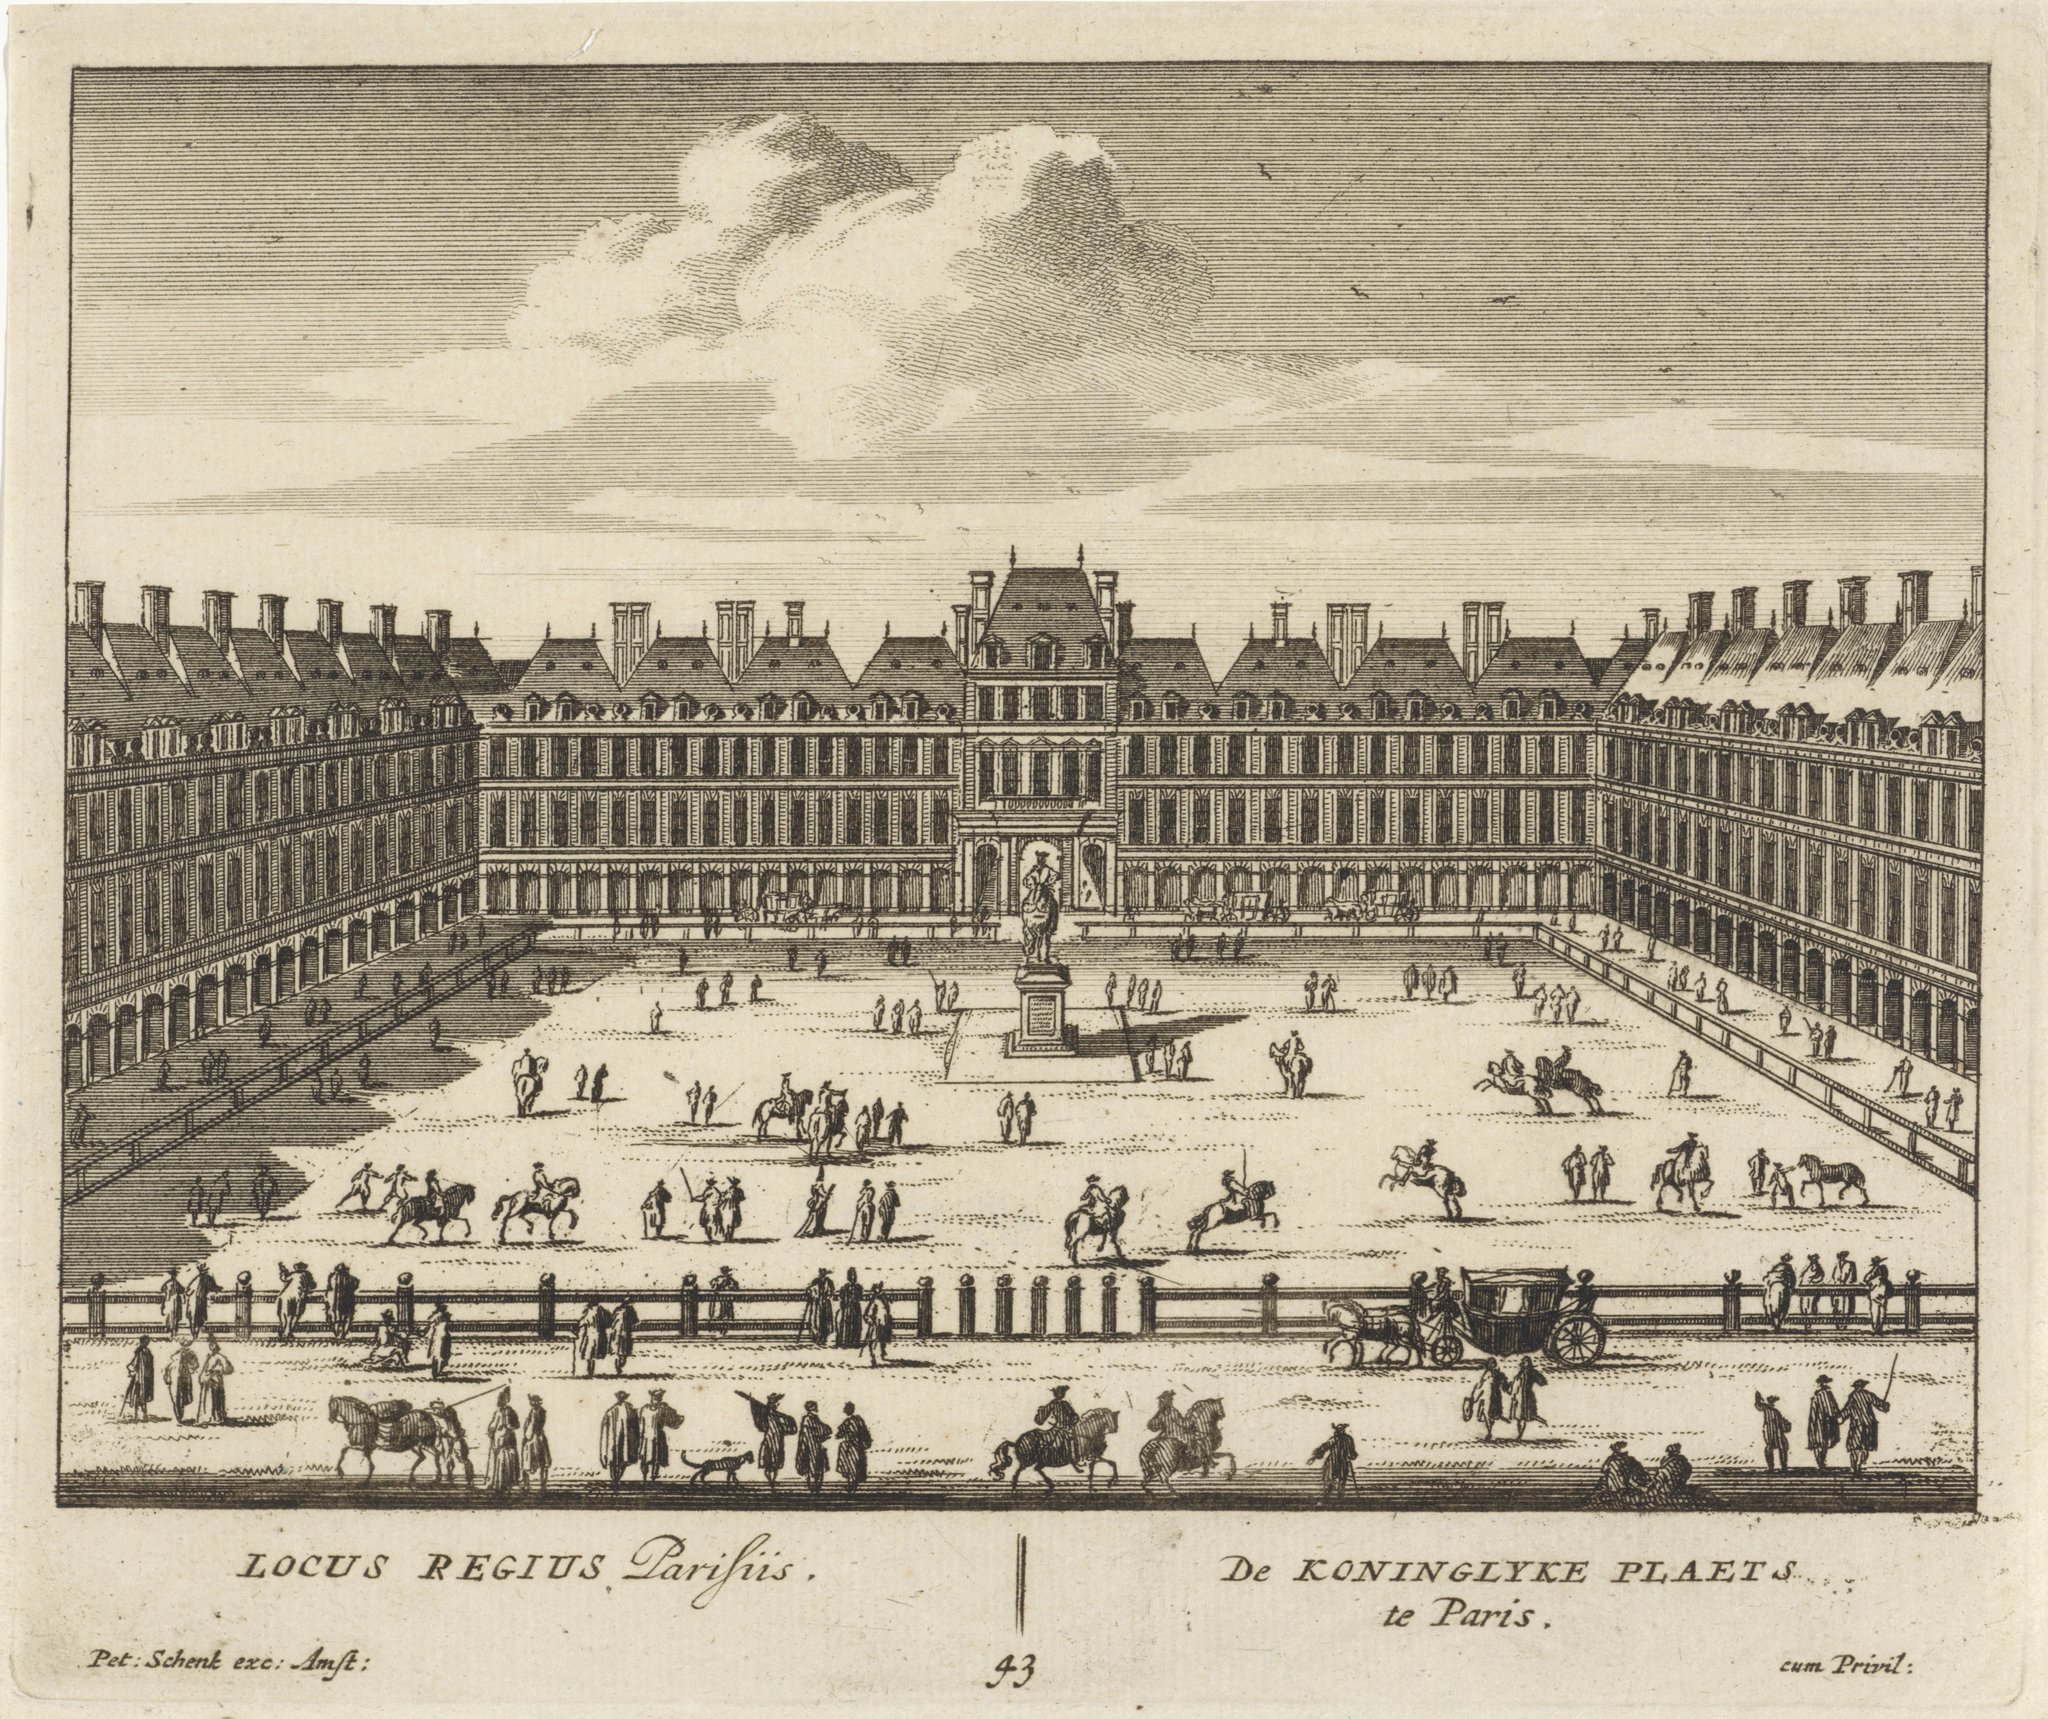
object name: print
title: Gezichten op Parijs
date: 1675-1711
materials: paper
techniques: etching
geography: amsterdam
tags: palais du louvre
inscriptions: collector's mark: Lugt 2228